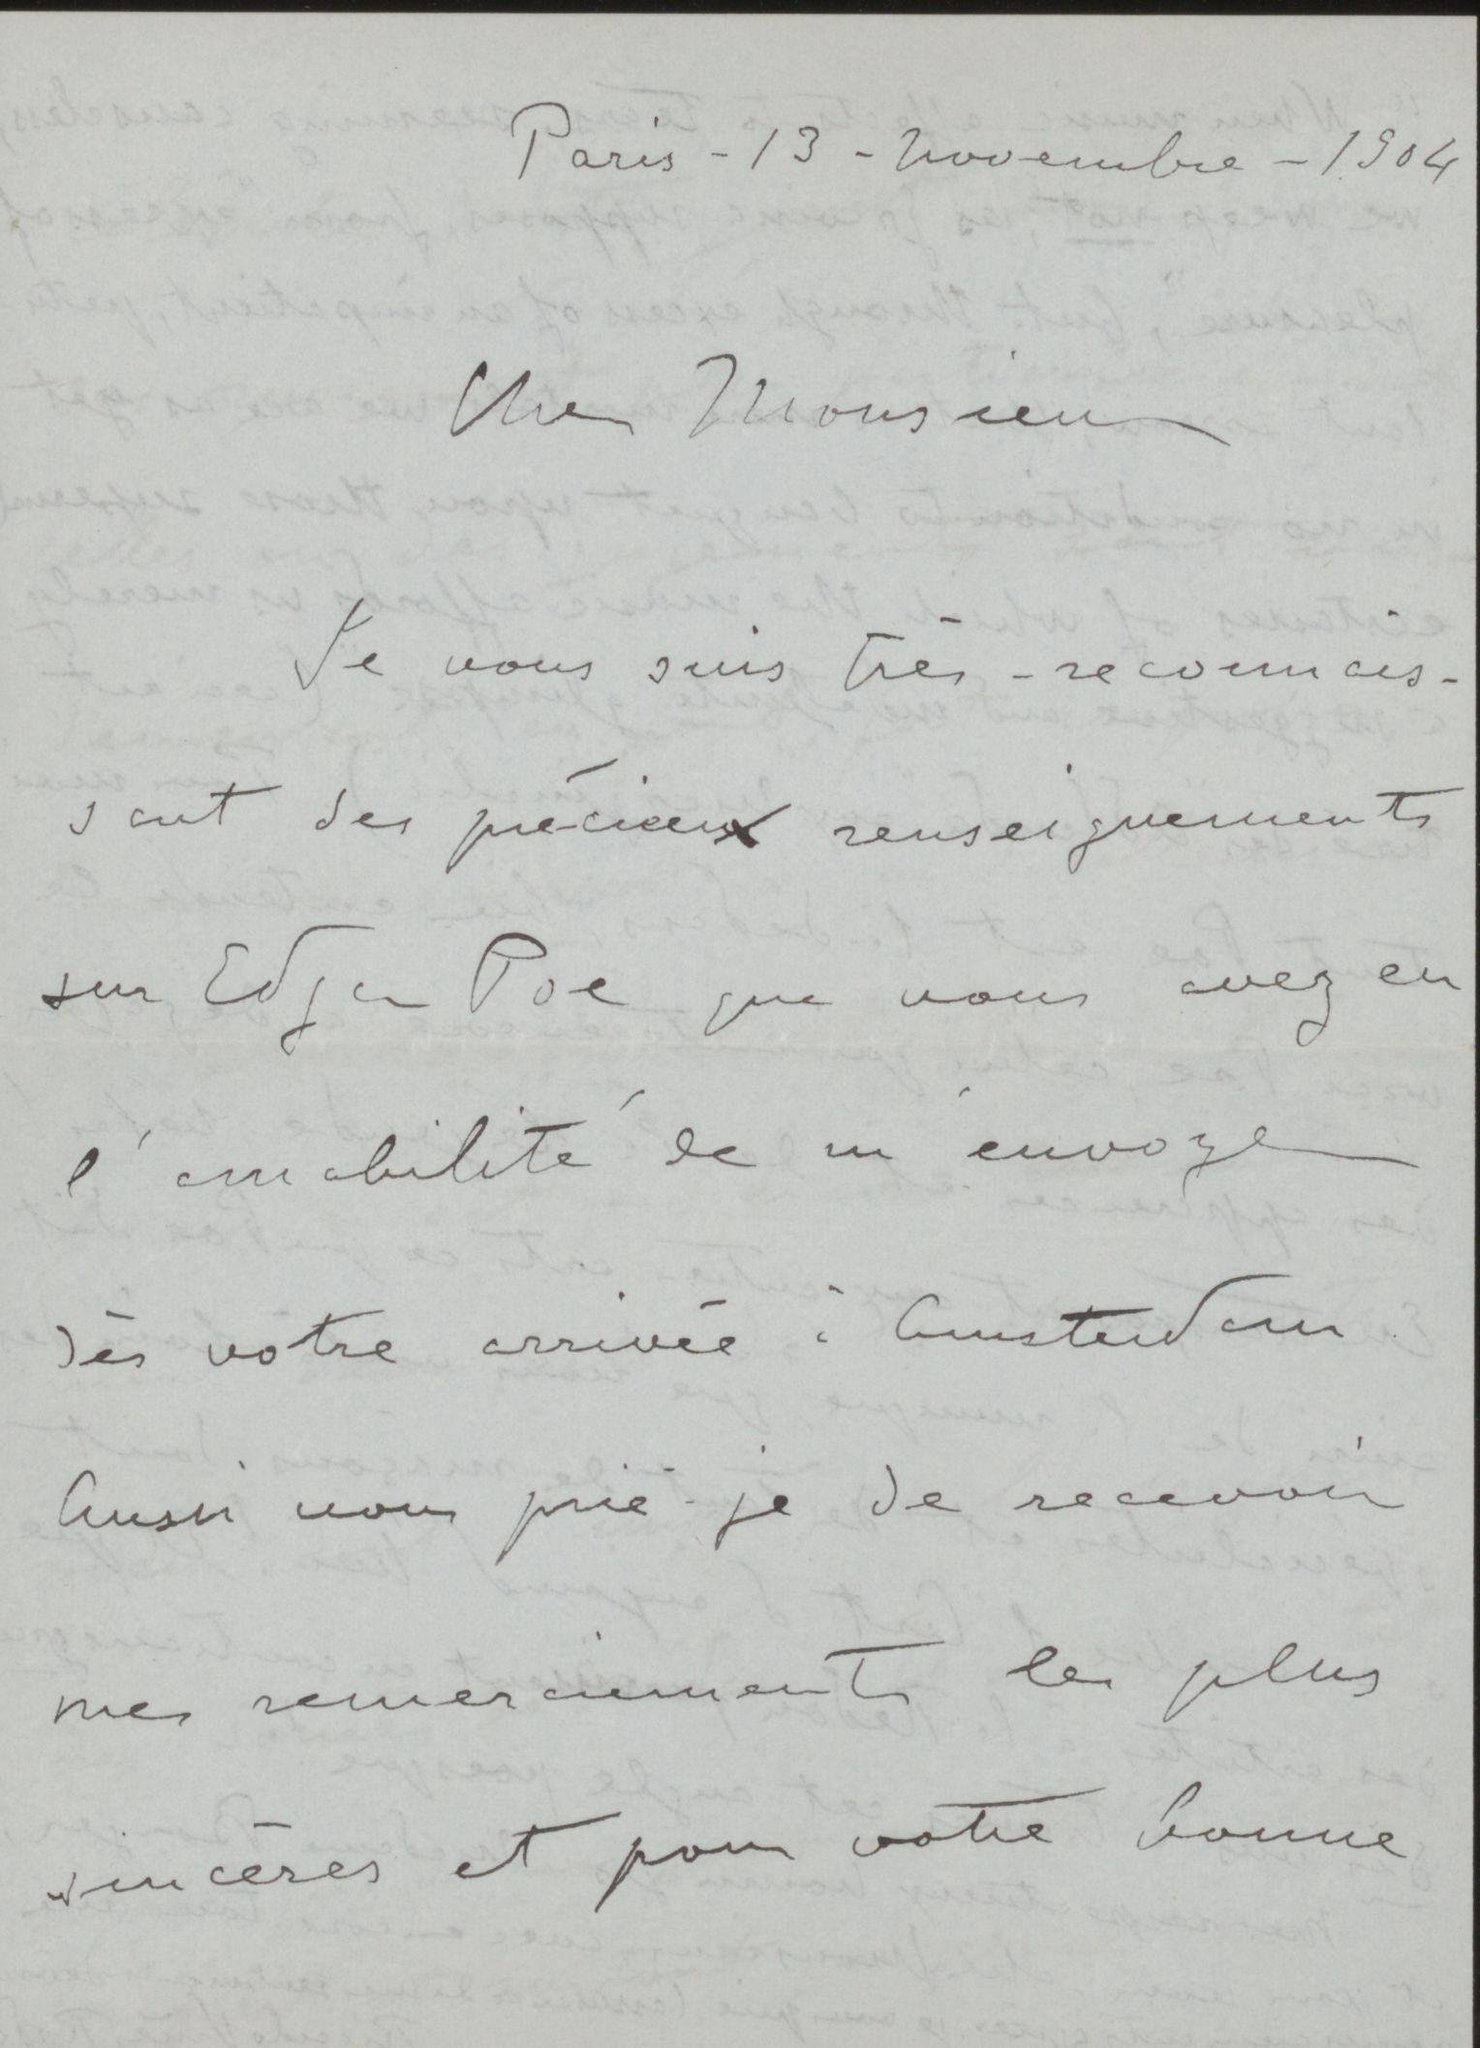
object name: letter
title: Brief aan Andries Bonger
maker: ricardo viñes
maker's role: pianist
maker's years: 1875-1943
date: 1904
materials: ink, paper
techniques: pen, writing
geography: paris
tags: paris, painter, odilon redon, andries bonger, edgar allan poe, music, literature ~ arts, amsterdam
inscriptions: watermark